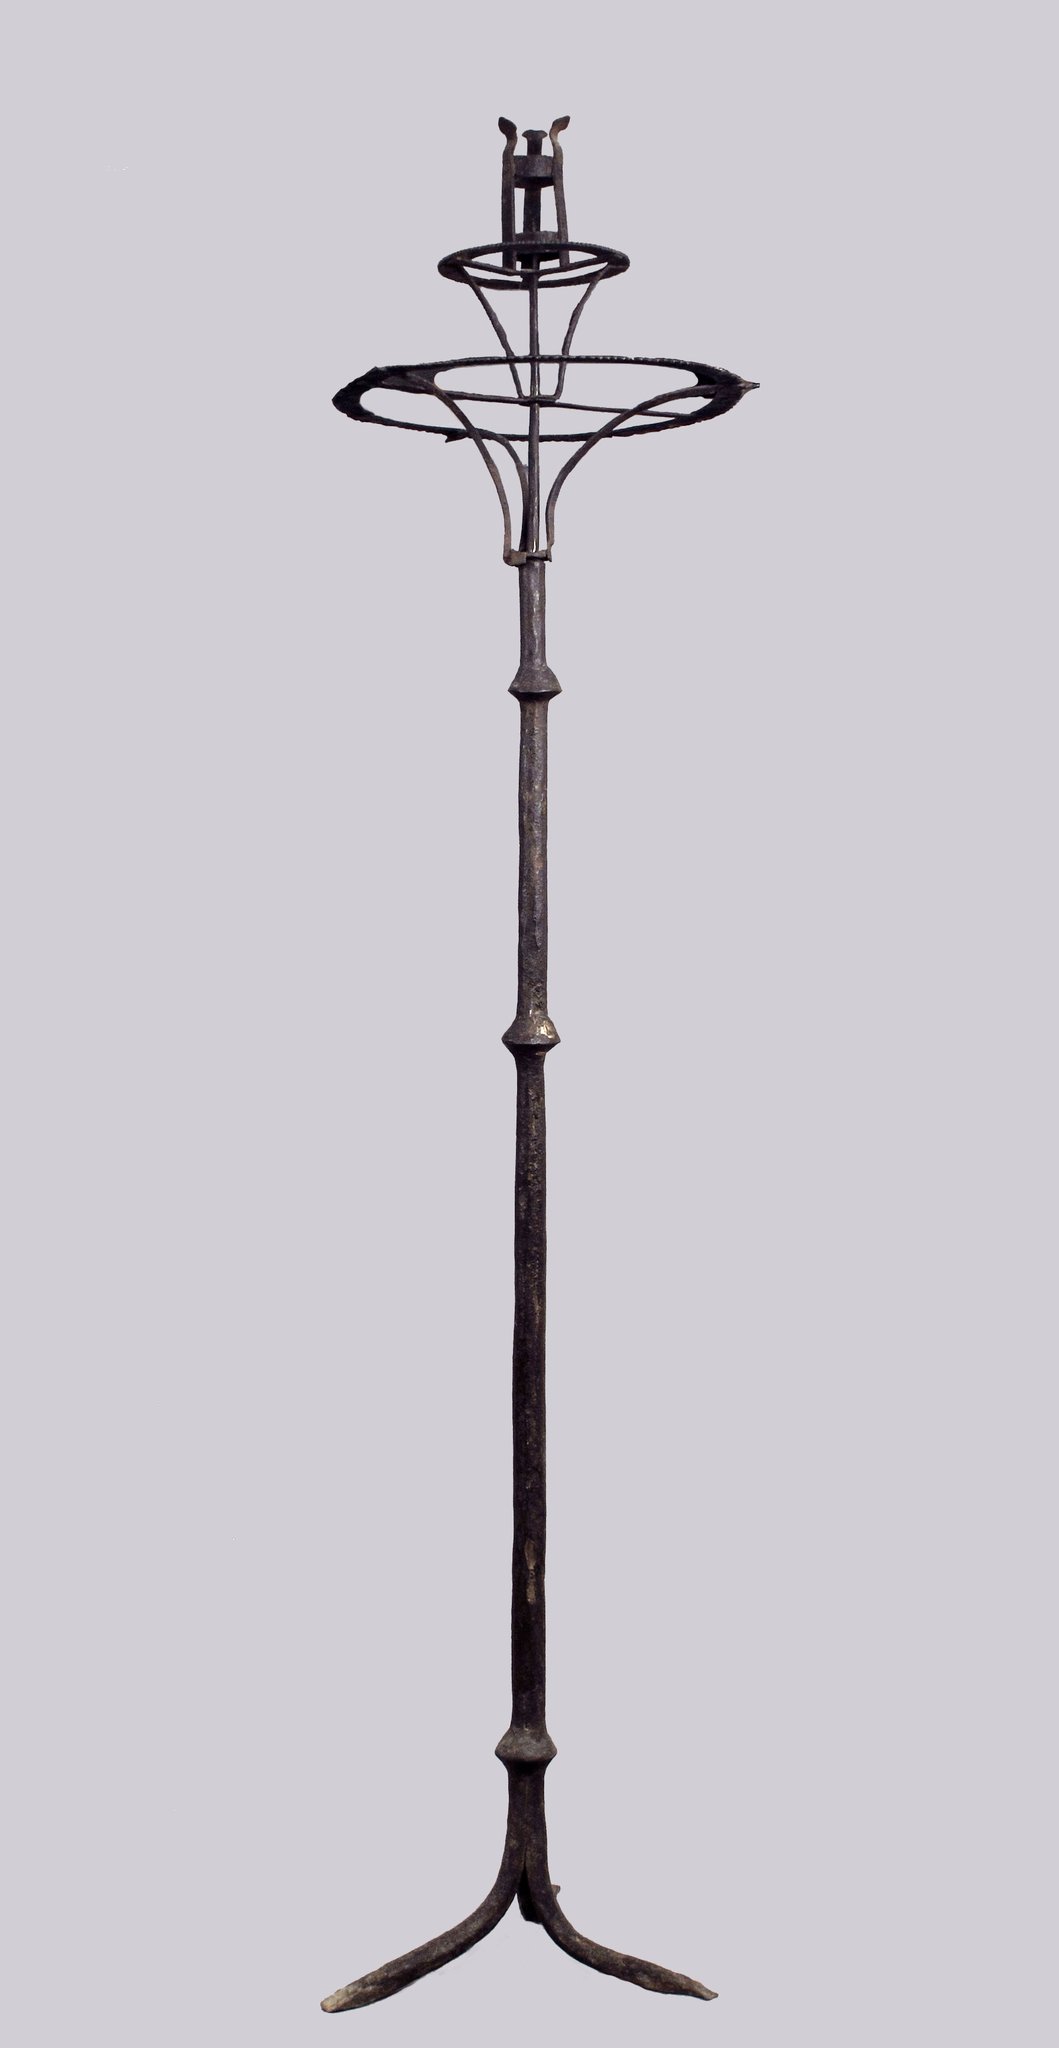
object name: candelabrum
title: Candelabra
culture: spanish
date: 1501-1600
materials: iron